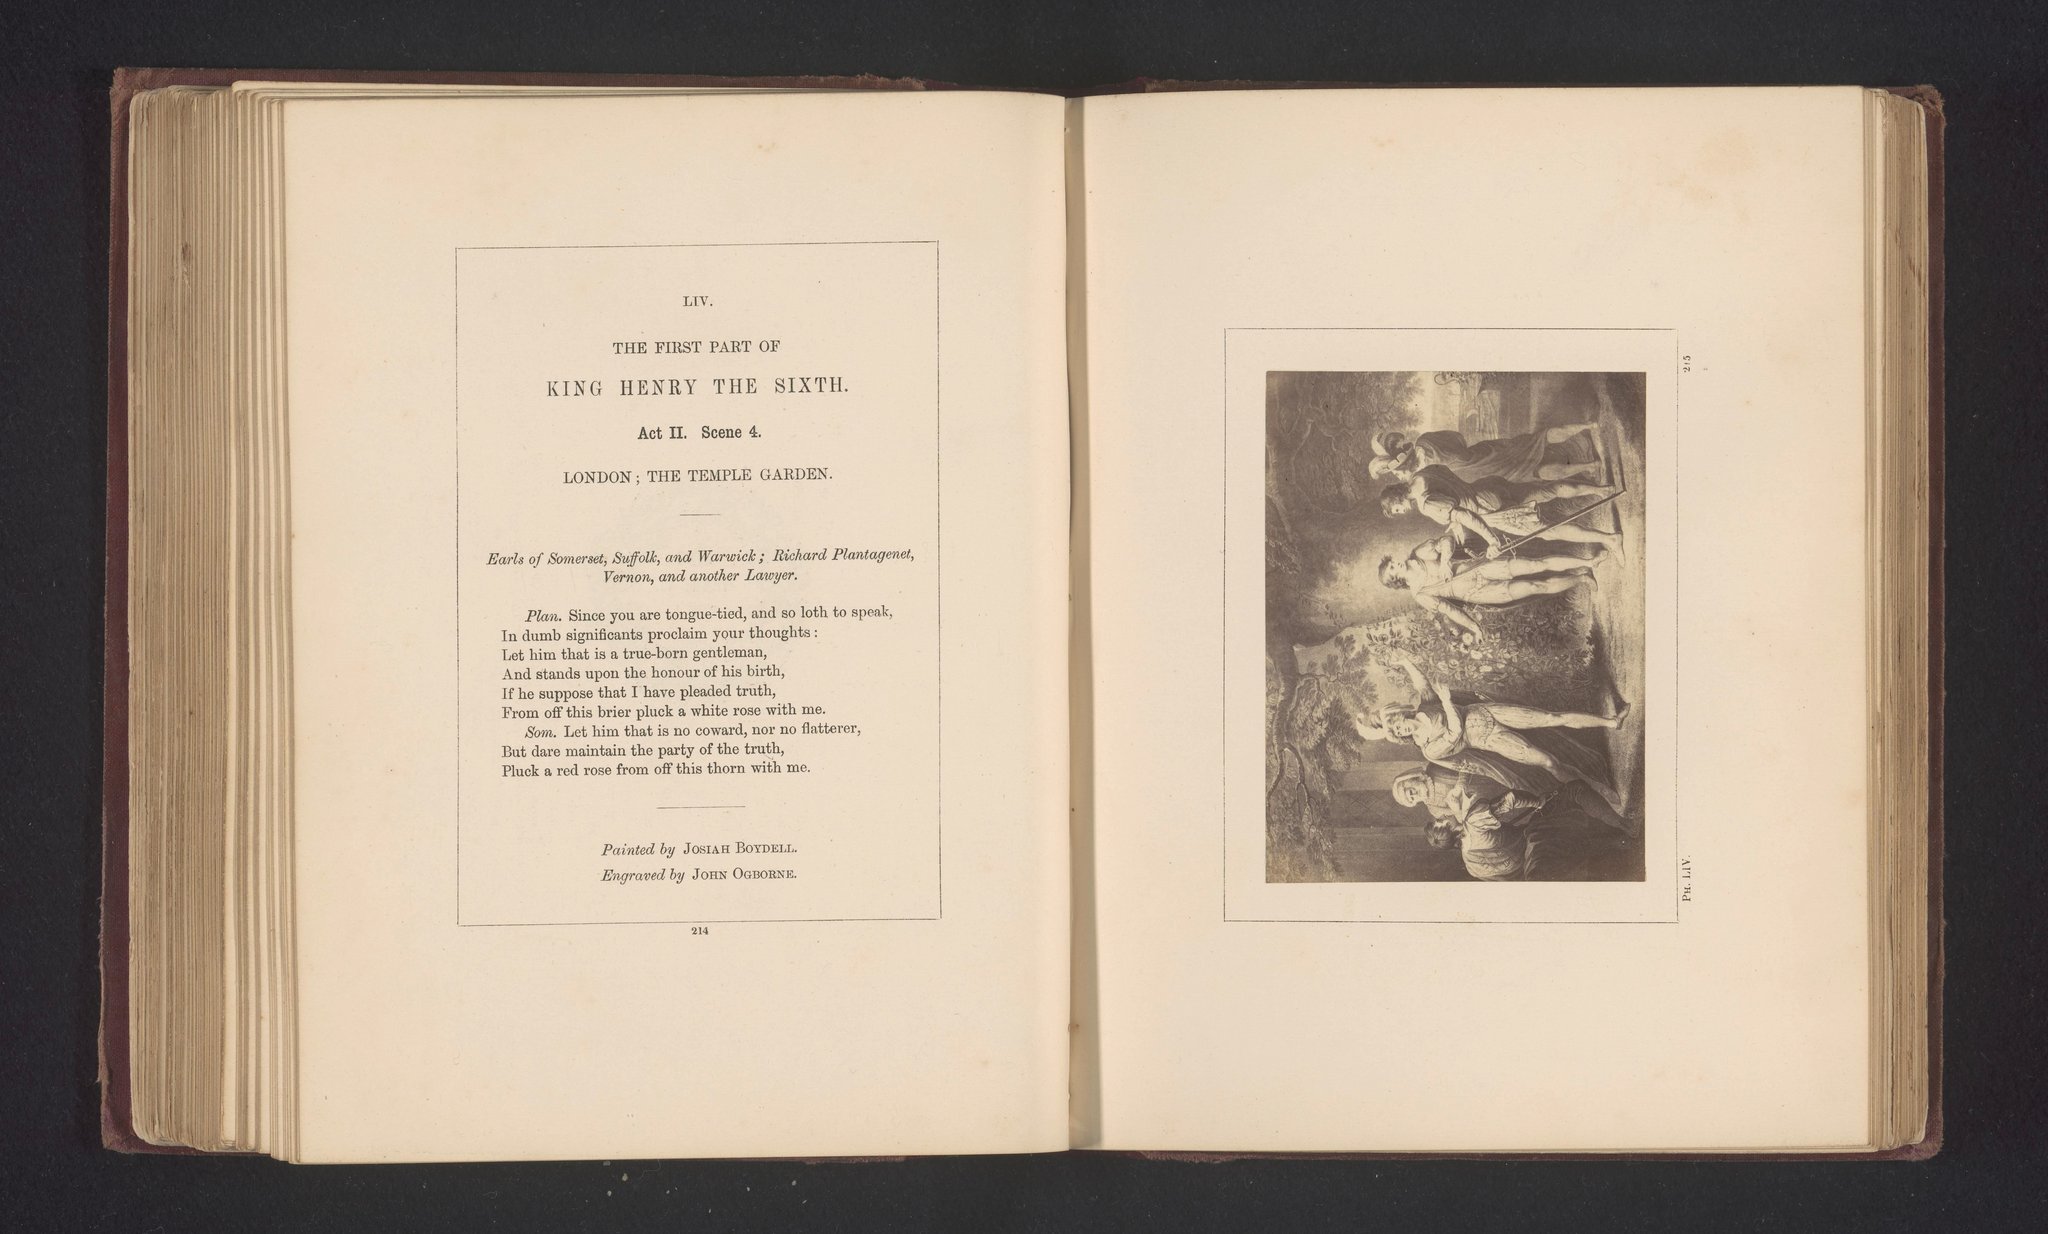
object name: page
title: Fotoreproductie van een prent naar een schilderij door Josiah Boydell, voorstellend een scene uit Hendrik VI, deel 1 door William Shakespeare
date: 1854-1867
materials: photographic support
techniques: albumen print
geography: london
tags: specific works of literature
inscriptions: number: ‘Ph. LIV. 215’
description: Te zien is akte II, scene 4 met een gezelschap van mannen in de Temple Garden in Londen.